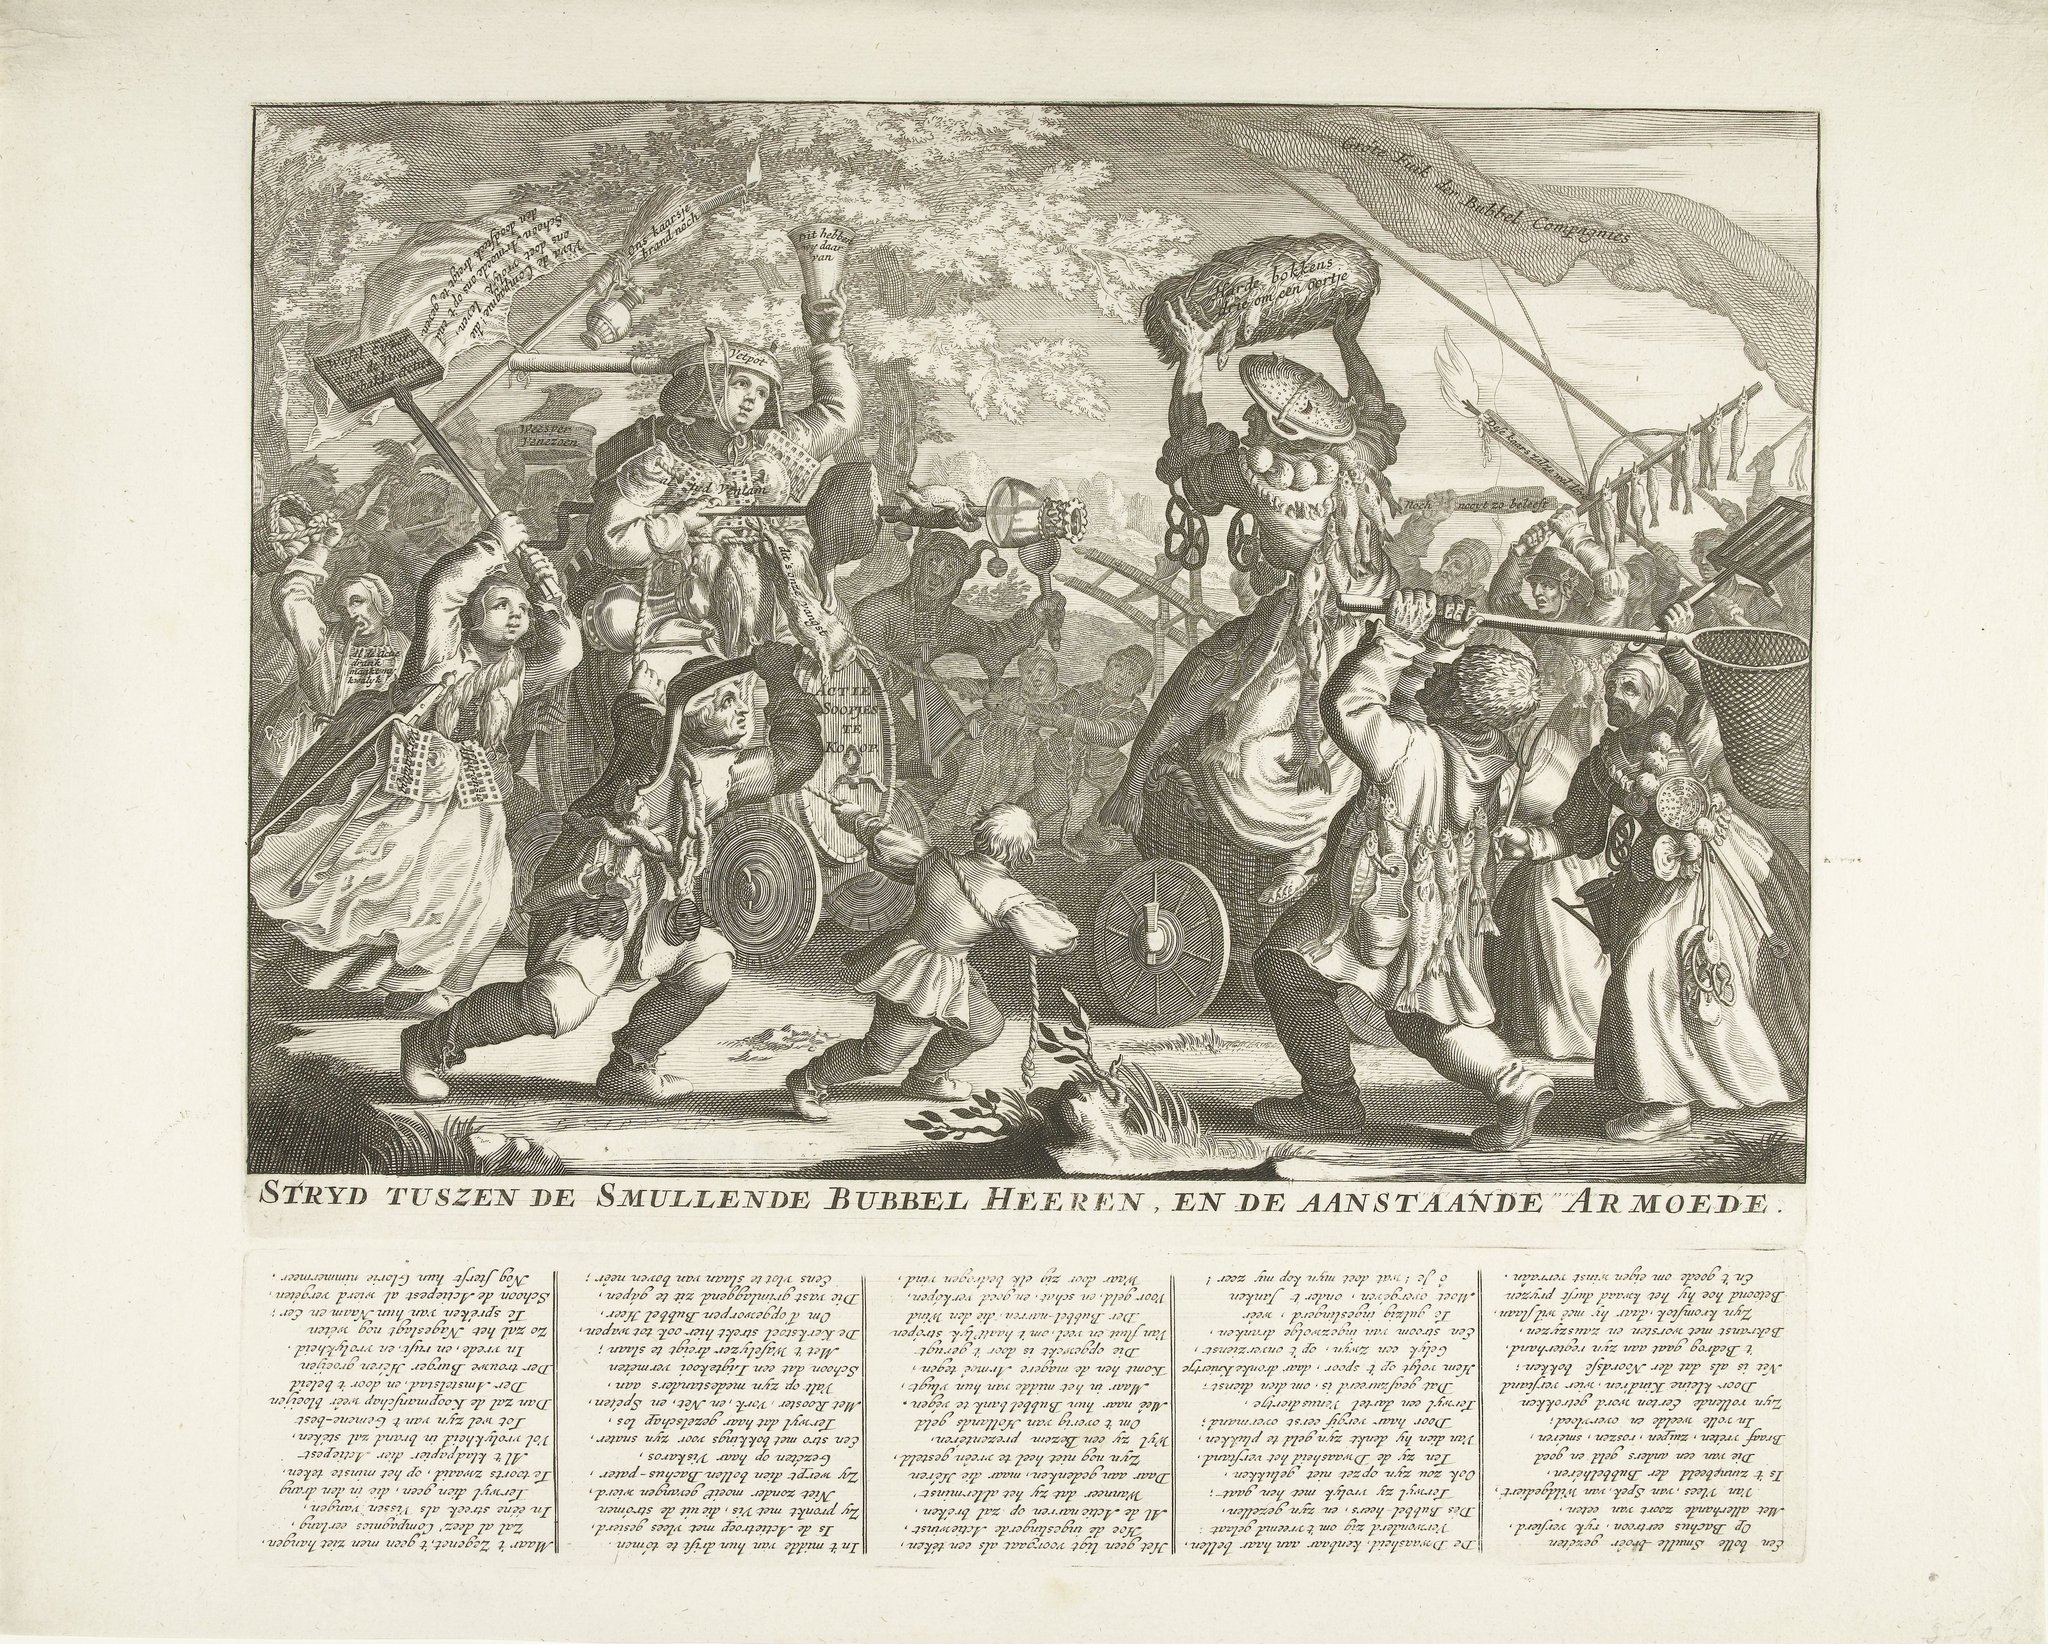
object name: cartoon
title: Het Groote Tafereel der Dwaasheid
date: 1600-1633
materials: paper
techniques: engraving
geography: northern netherlands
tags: strife of lent and carnival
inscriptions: collector's mark: Lugt 2228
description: Spotprent met de strijd tussen Vastenavond en Vasten geplaatst in de context van de Windhandel van 1720. Strijd tussen twee personen op strijdwagens getrokken door kinderen. Links Vastenavond, aangekleed met keukeninstrumenten, wild en gevogelte, drinkglazen en kannen. Zij en haar aanhangers dragen verwijzingen naar de actiehandel. Rechts Vasten, aangekleed met vissen en krakelingen, verwijst naar de aanstaande armoede. In het onderschrift een vers in vijf kolommen, onderste boven gedrukt van een aparte plaat. Prent 25 in de serie Het Groote Tafereel der Dwaasheid met spotprenten op de Windhandel of Actiehandel van 1720.